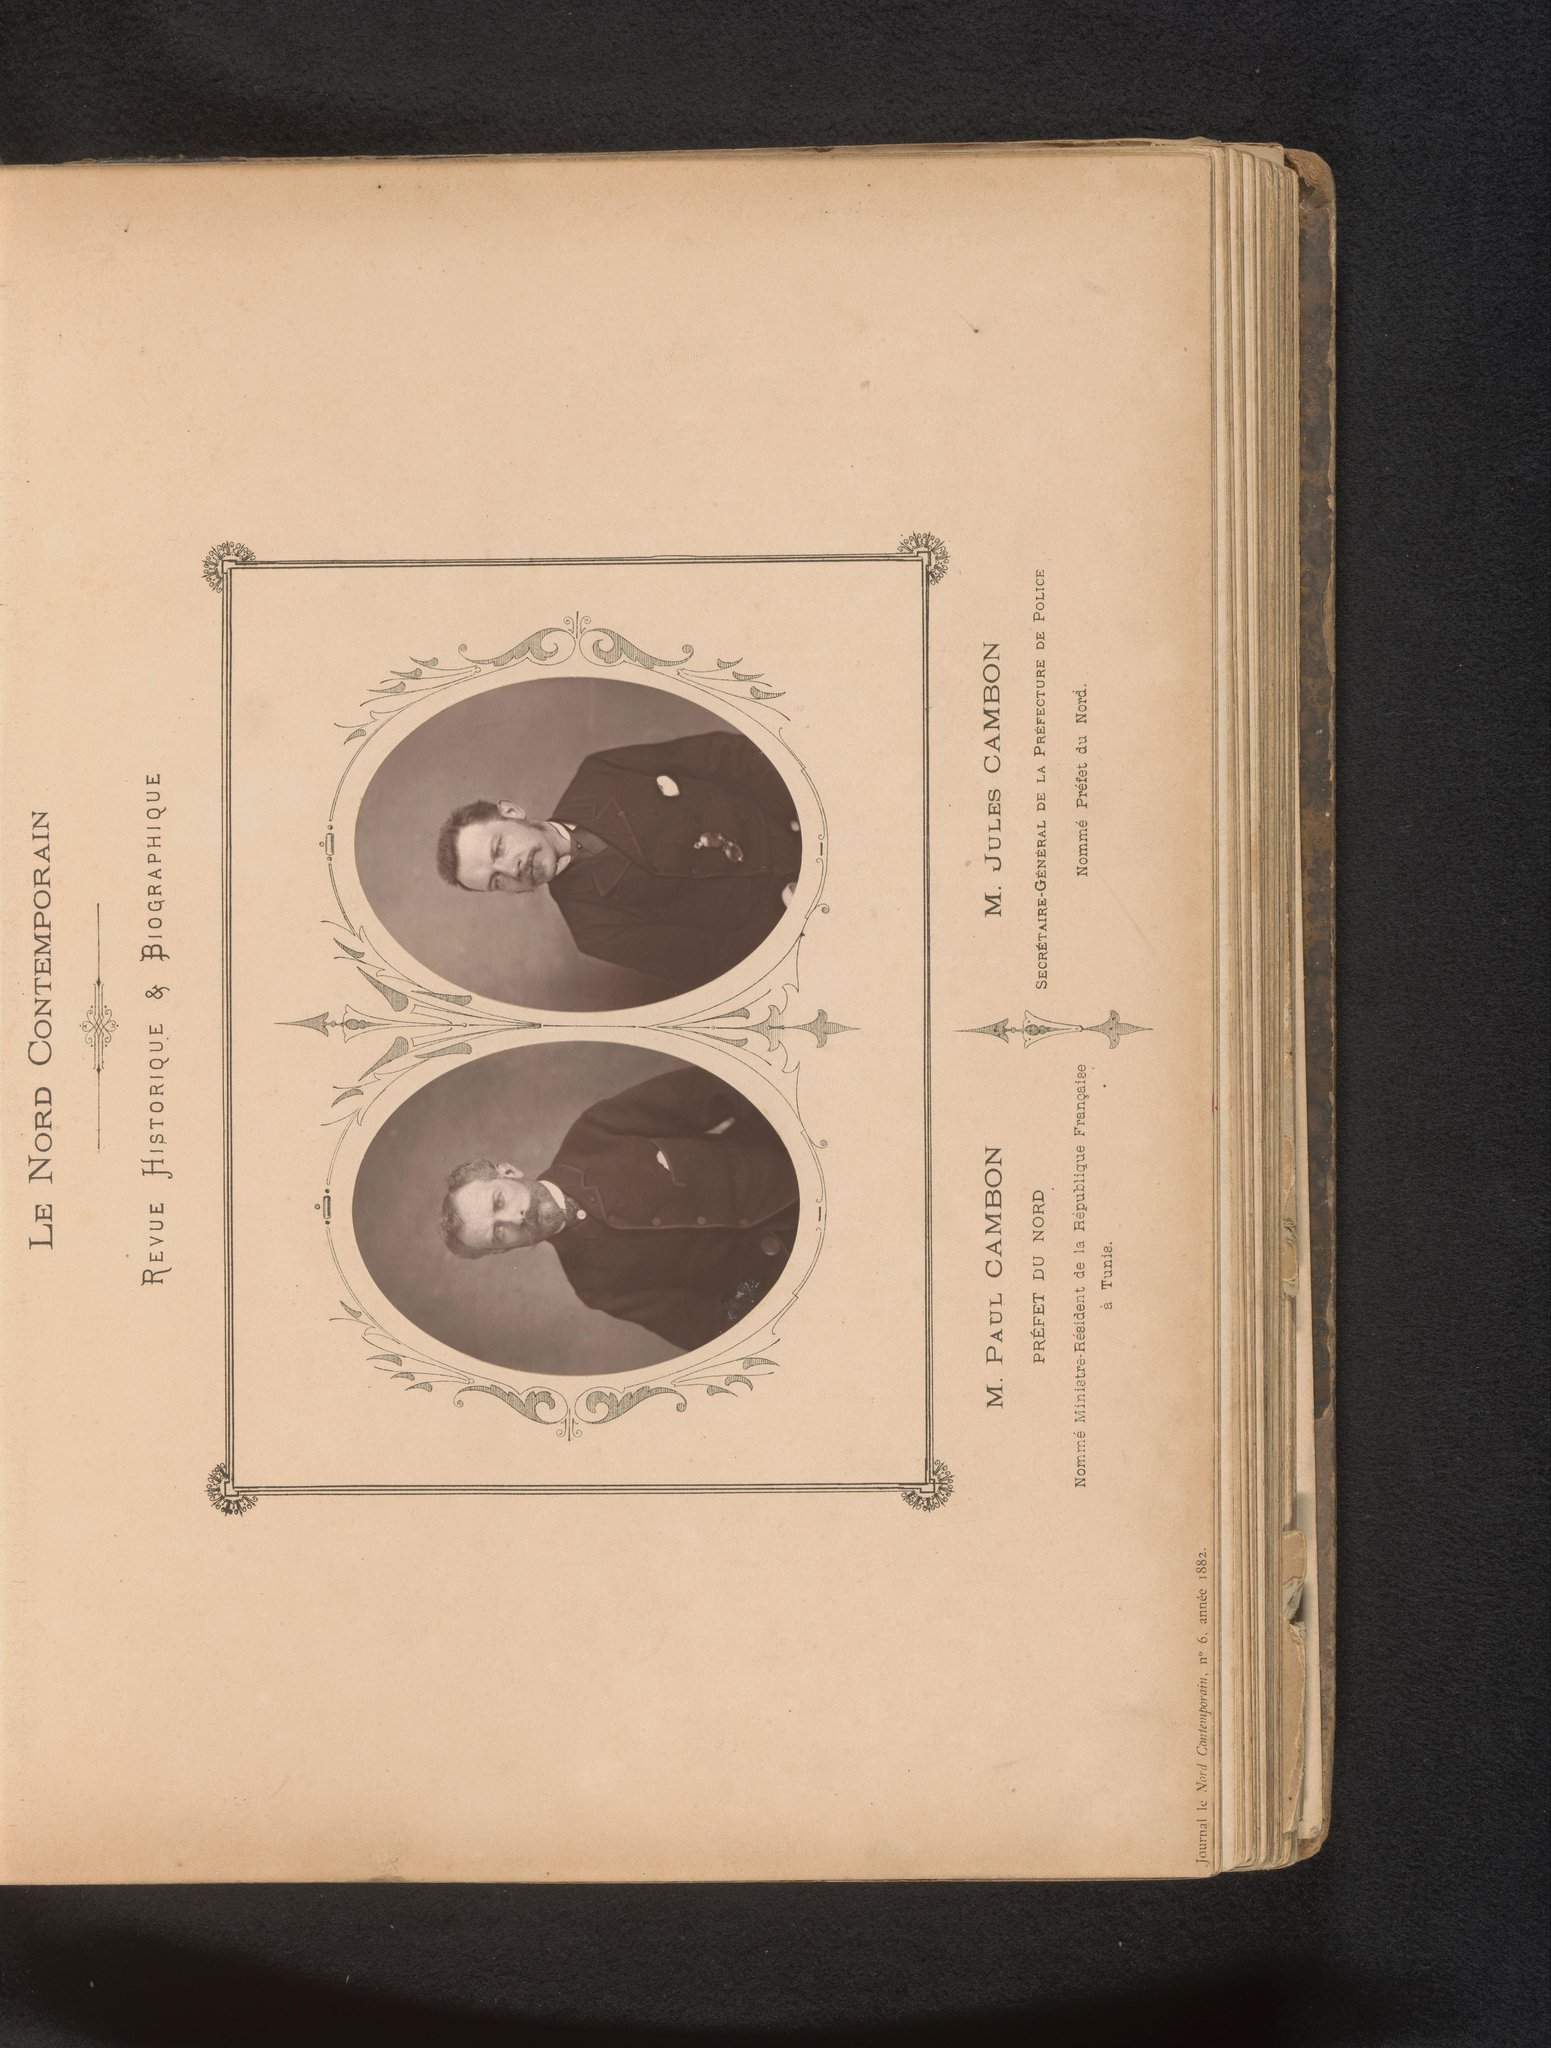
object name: page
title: M. Paul Cambon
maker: Anonymous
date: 1878-1882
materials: paper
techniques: woodburytype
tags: historical persons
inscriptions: inscription: ‘Journal le Nord Contemporain, No 6, année 1882’, inscription: ‘Préfet du Nord/ Nommé Ministre-Résident de la République Française à Tunis’, inscription: ‘Le Nord Contemporain/ Revue Historique & Biographique’